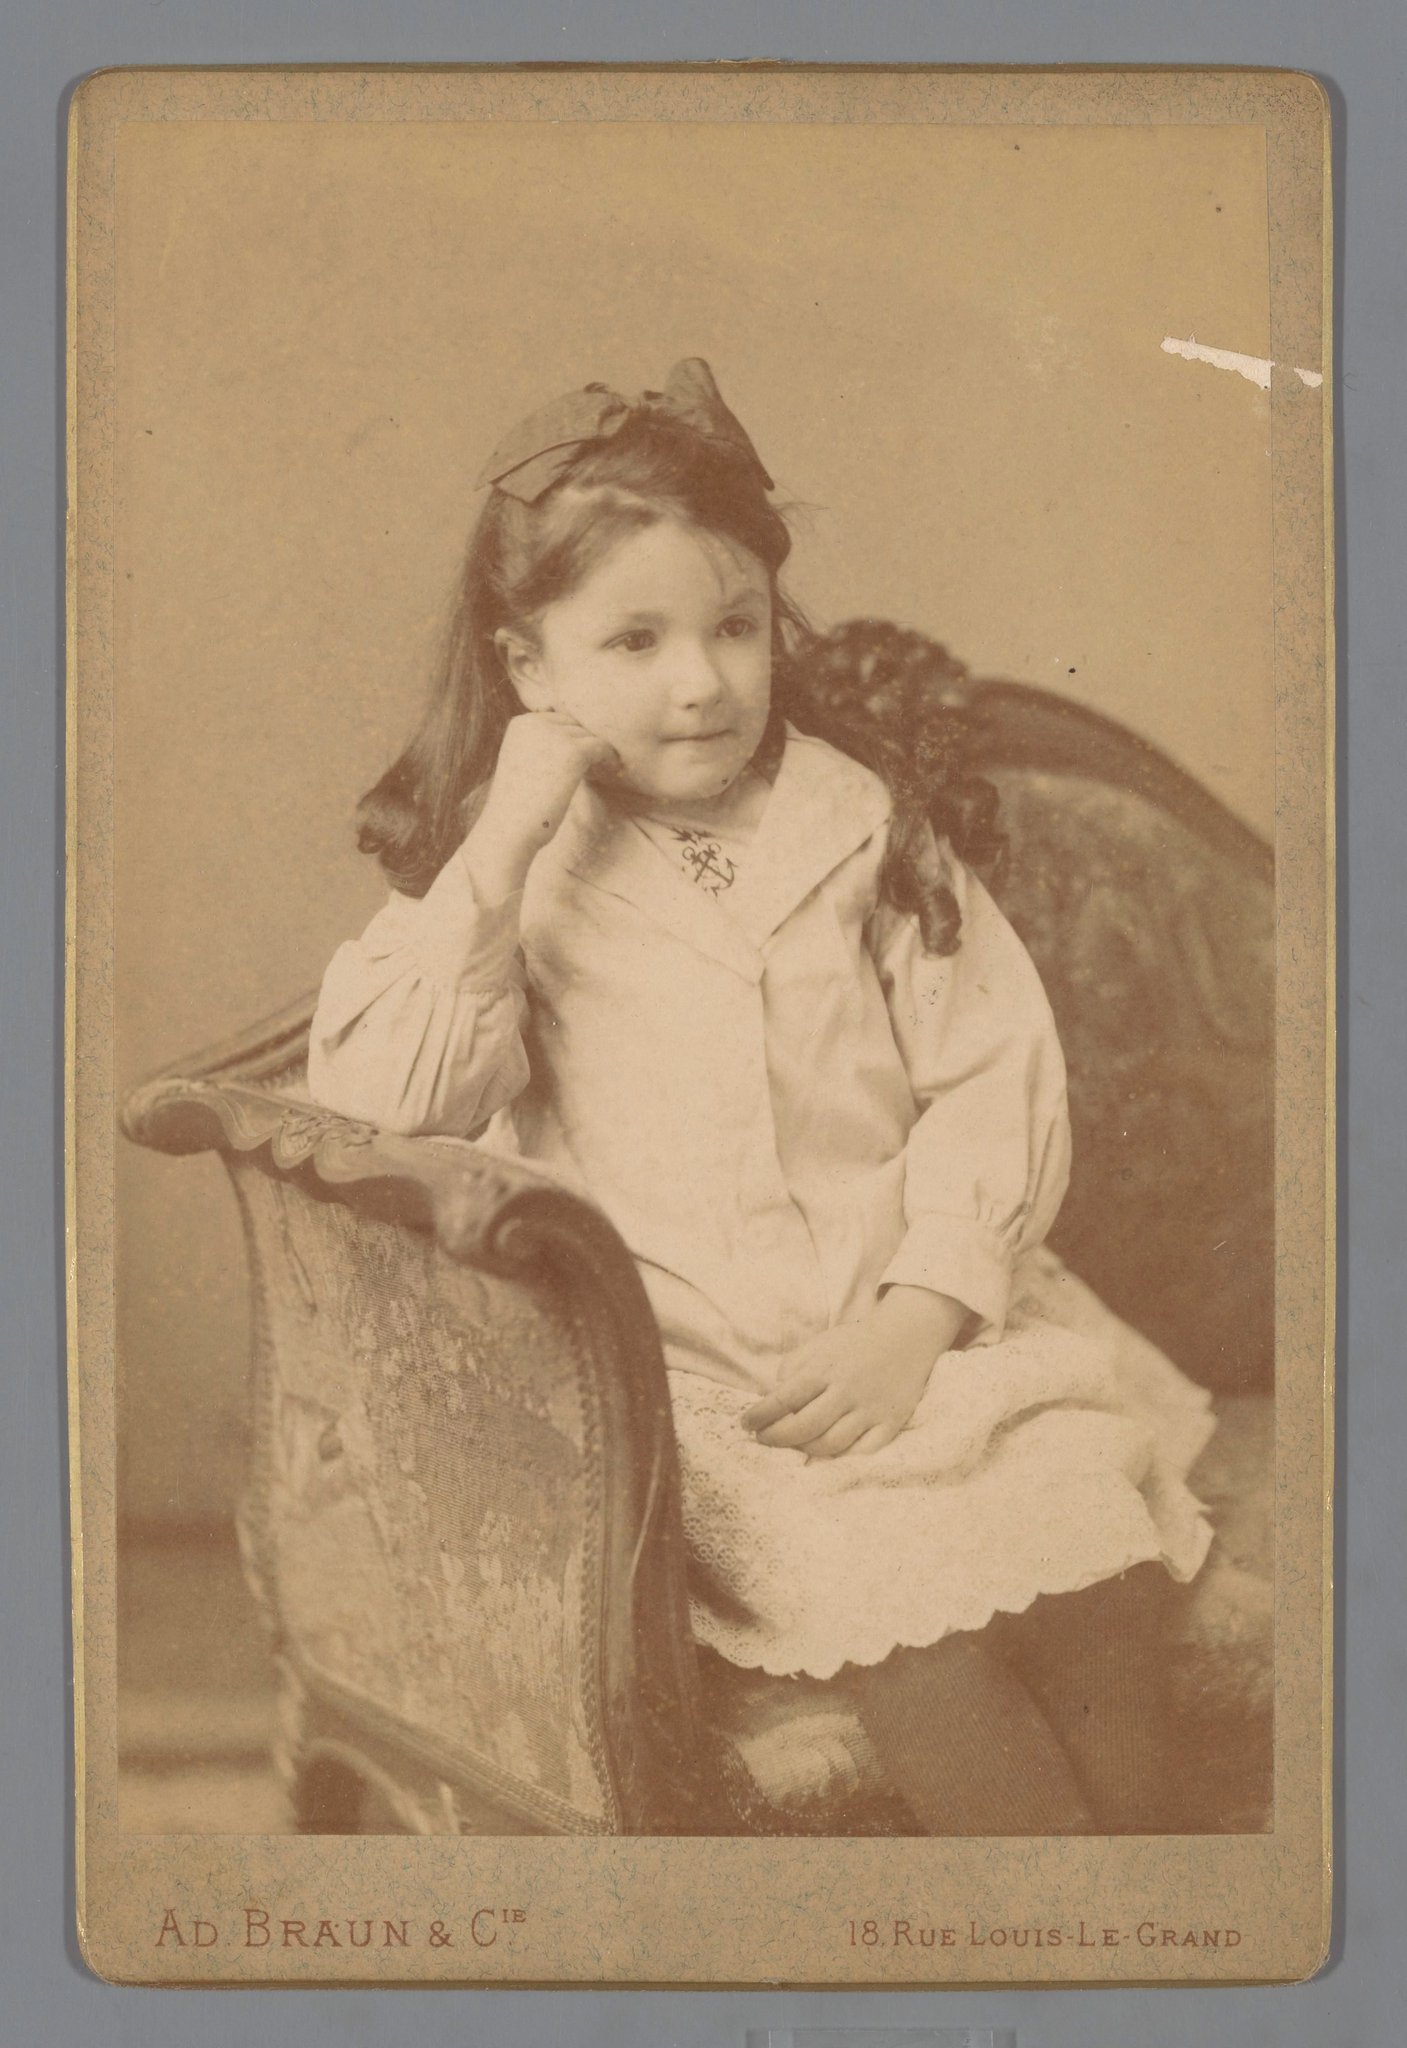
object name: cabinet photograph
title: Portret van een onbekend meisje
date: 1854-1900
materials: cardboard, photographic support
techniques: albumen print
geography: paris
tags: child (at home) - aa - girl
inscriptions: name: ‘Ad. Braun & Cie 18 Rue Louis le-Grand 18 (Avenue de l'Opera) Paris (...)’